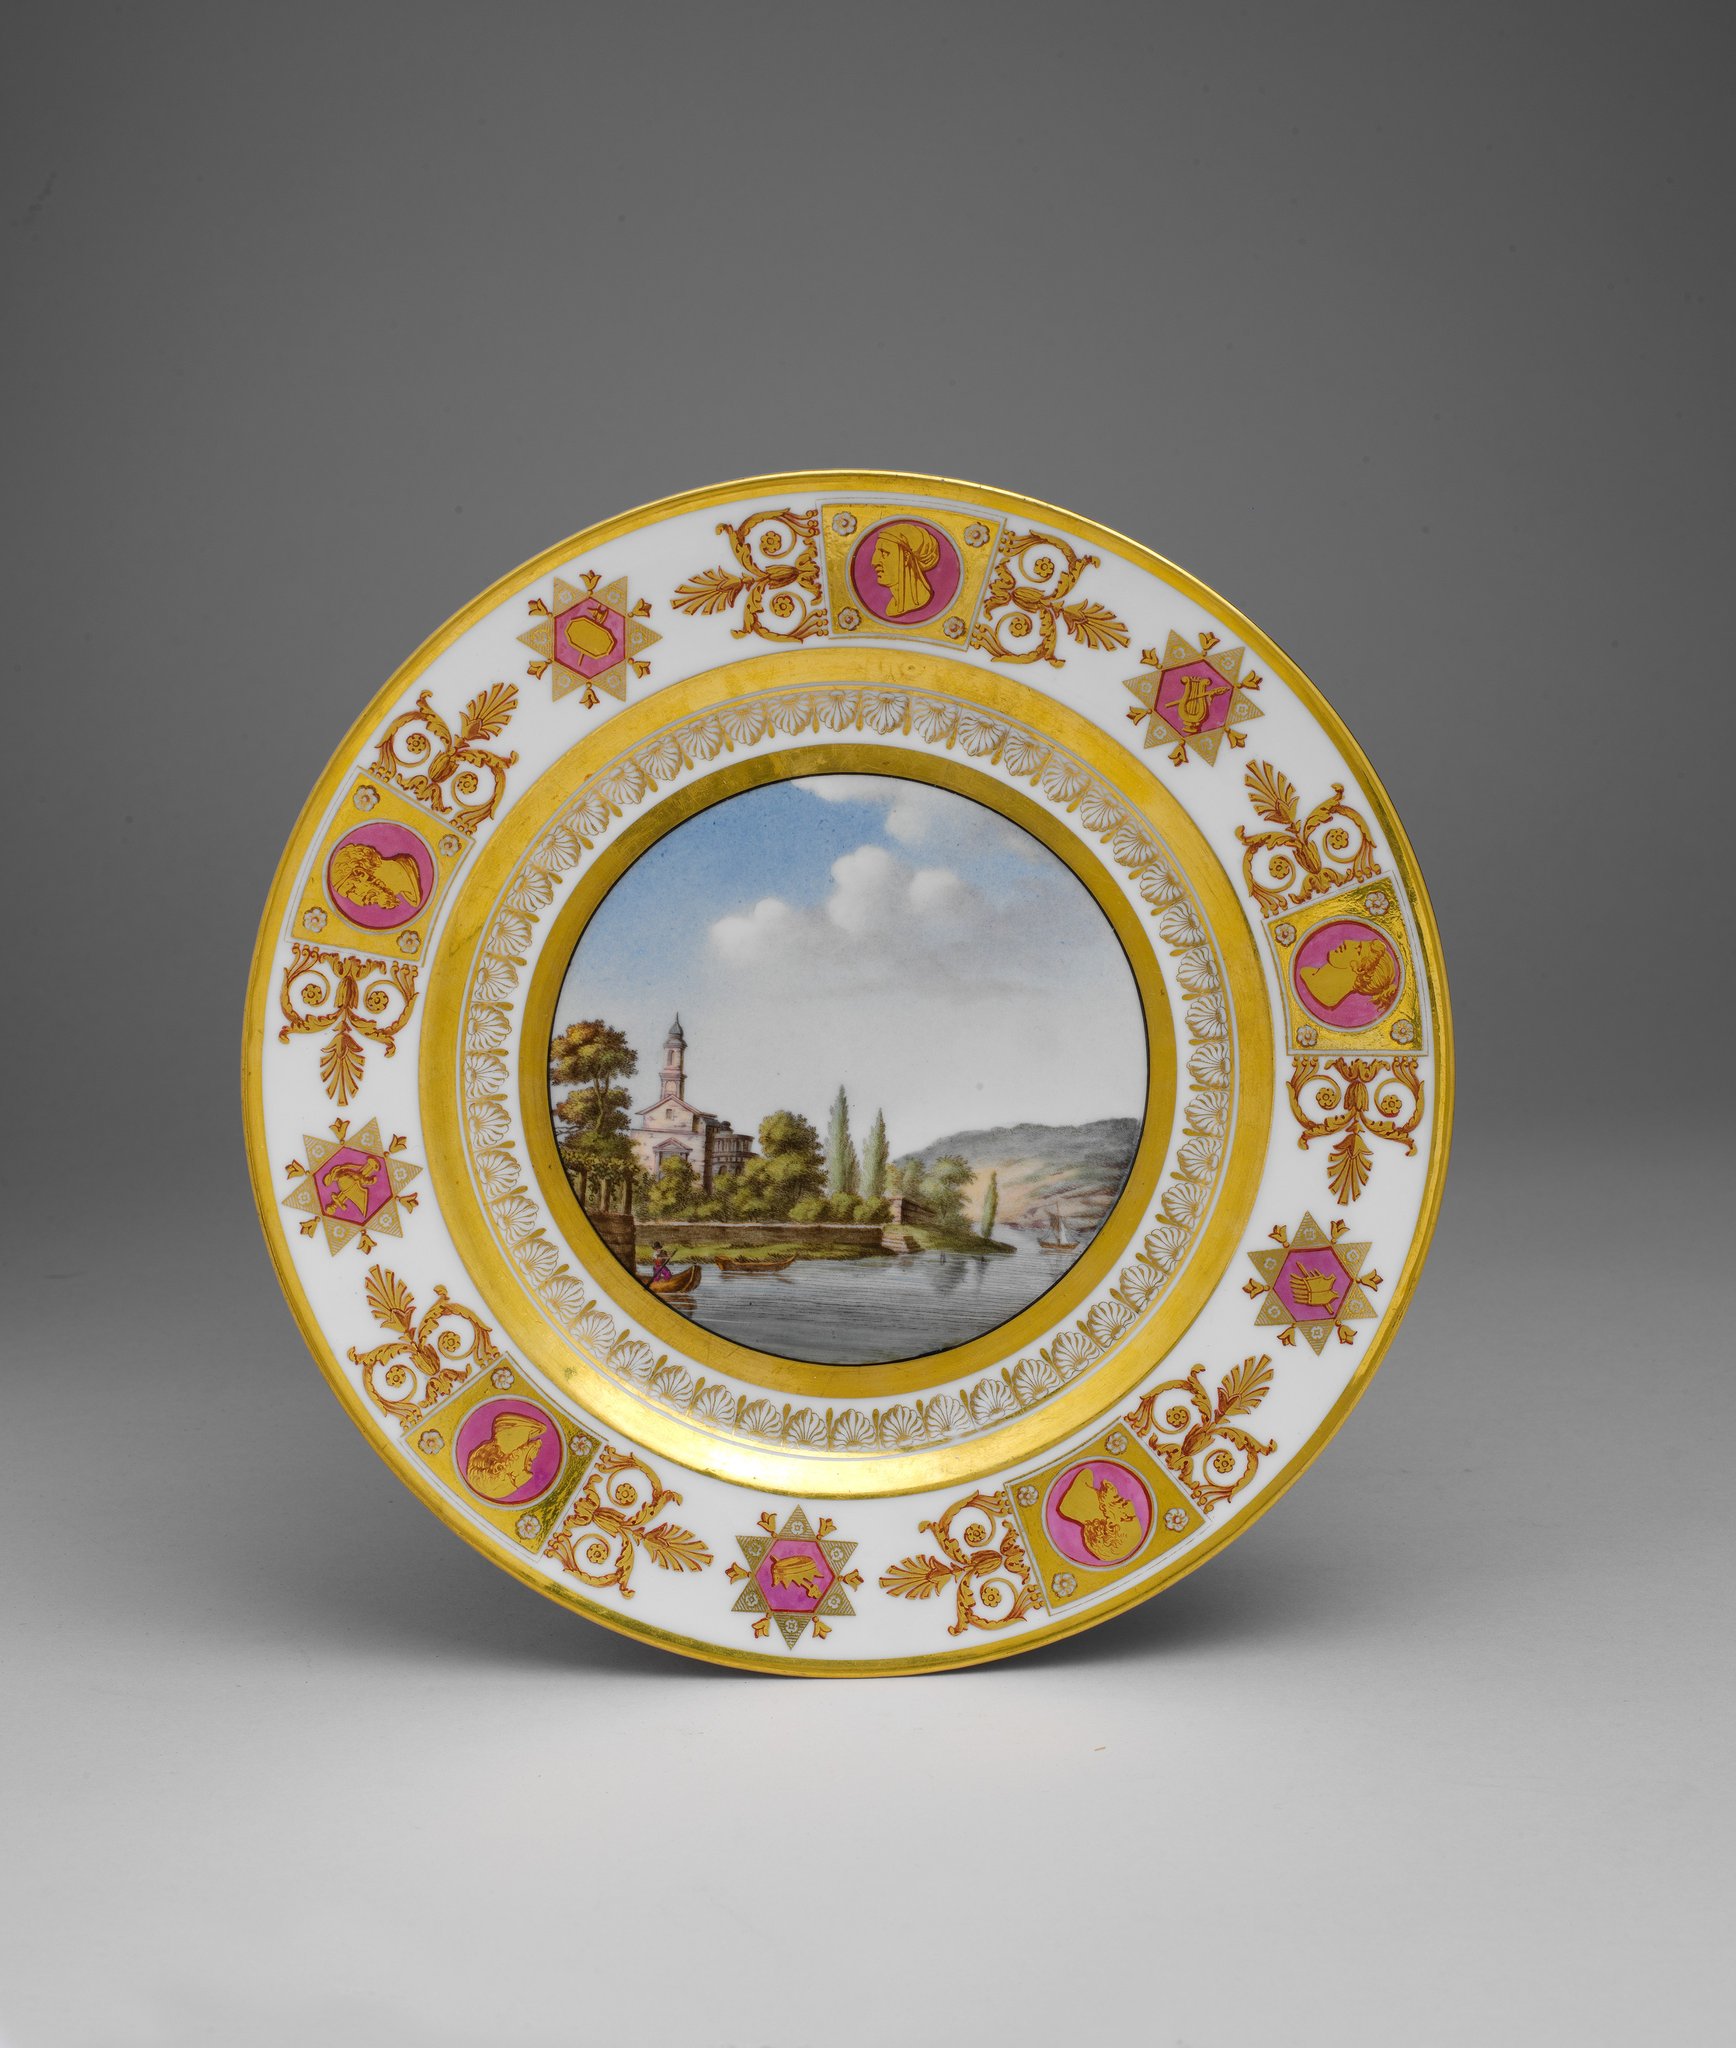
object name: plate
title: Lac de Lugano (from the Service des vues Suisses)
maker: sèvres manufactory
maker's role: manufactory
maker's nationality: french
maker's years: 1740-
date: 1811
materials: hard paste porcelain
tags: buildings,men,profiles,lakes